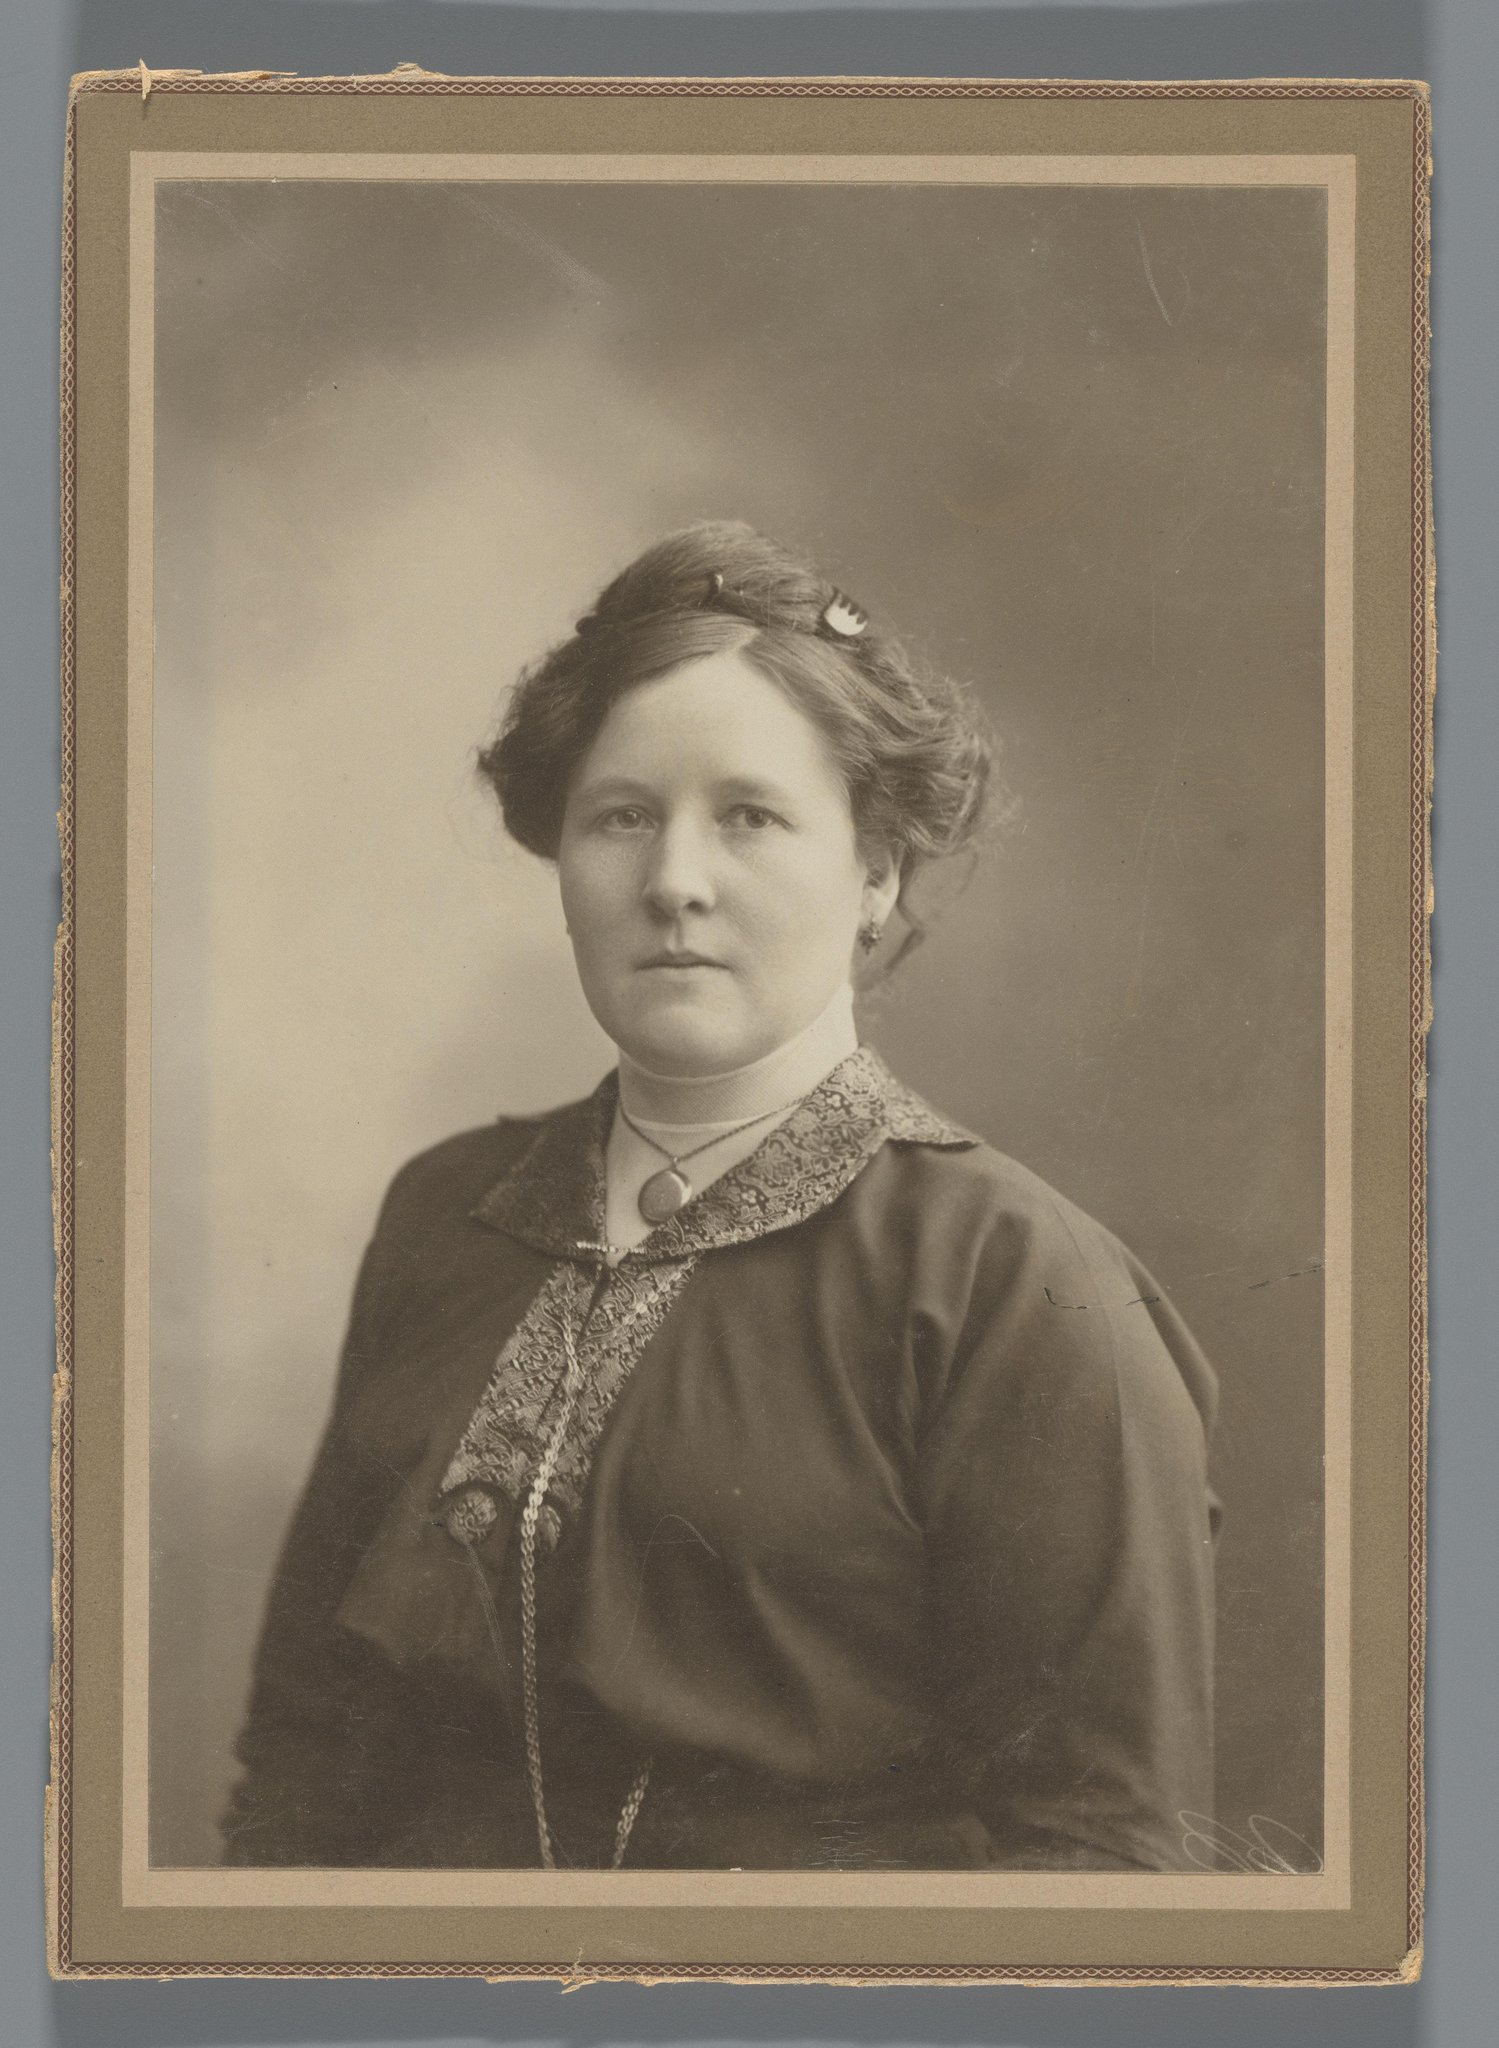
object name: photograph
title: Portret van een onbekende vrouw met een medaillon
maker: Anonymous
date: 1900-1920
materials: paper, cardboard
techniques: gelatin silver print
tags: historical persons - bb - woman, pendant, trinket, 'breloque'